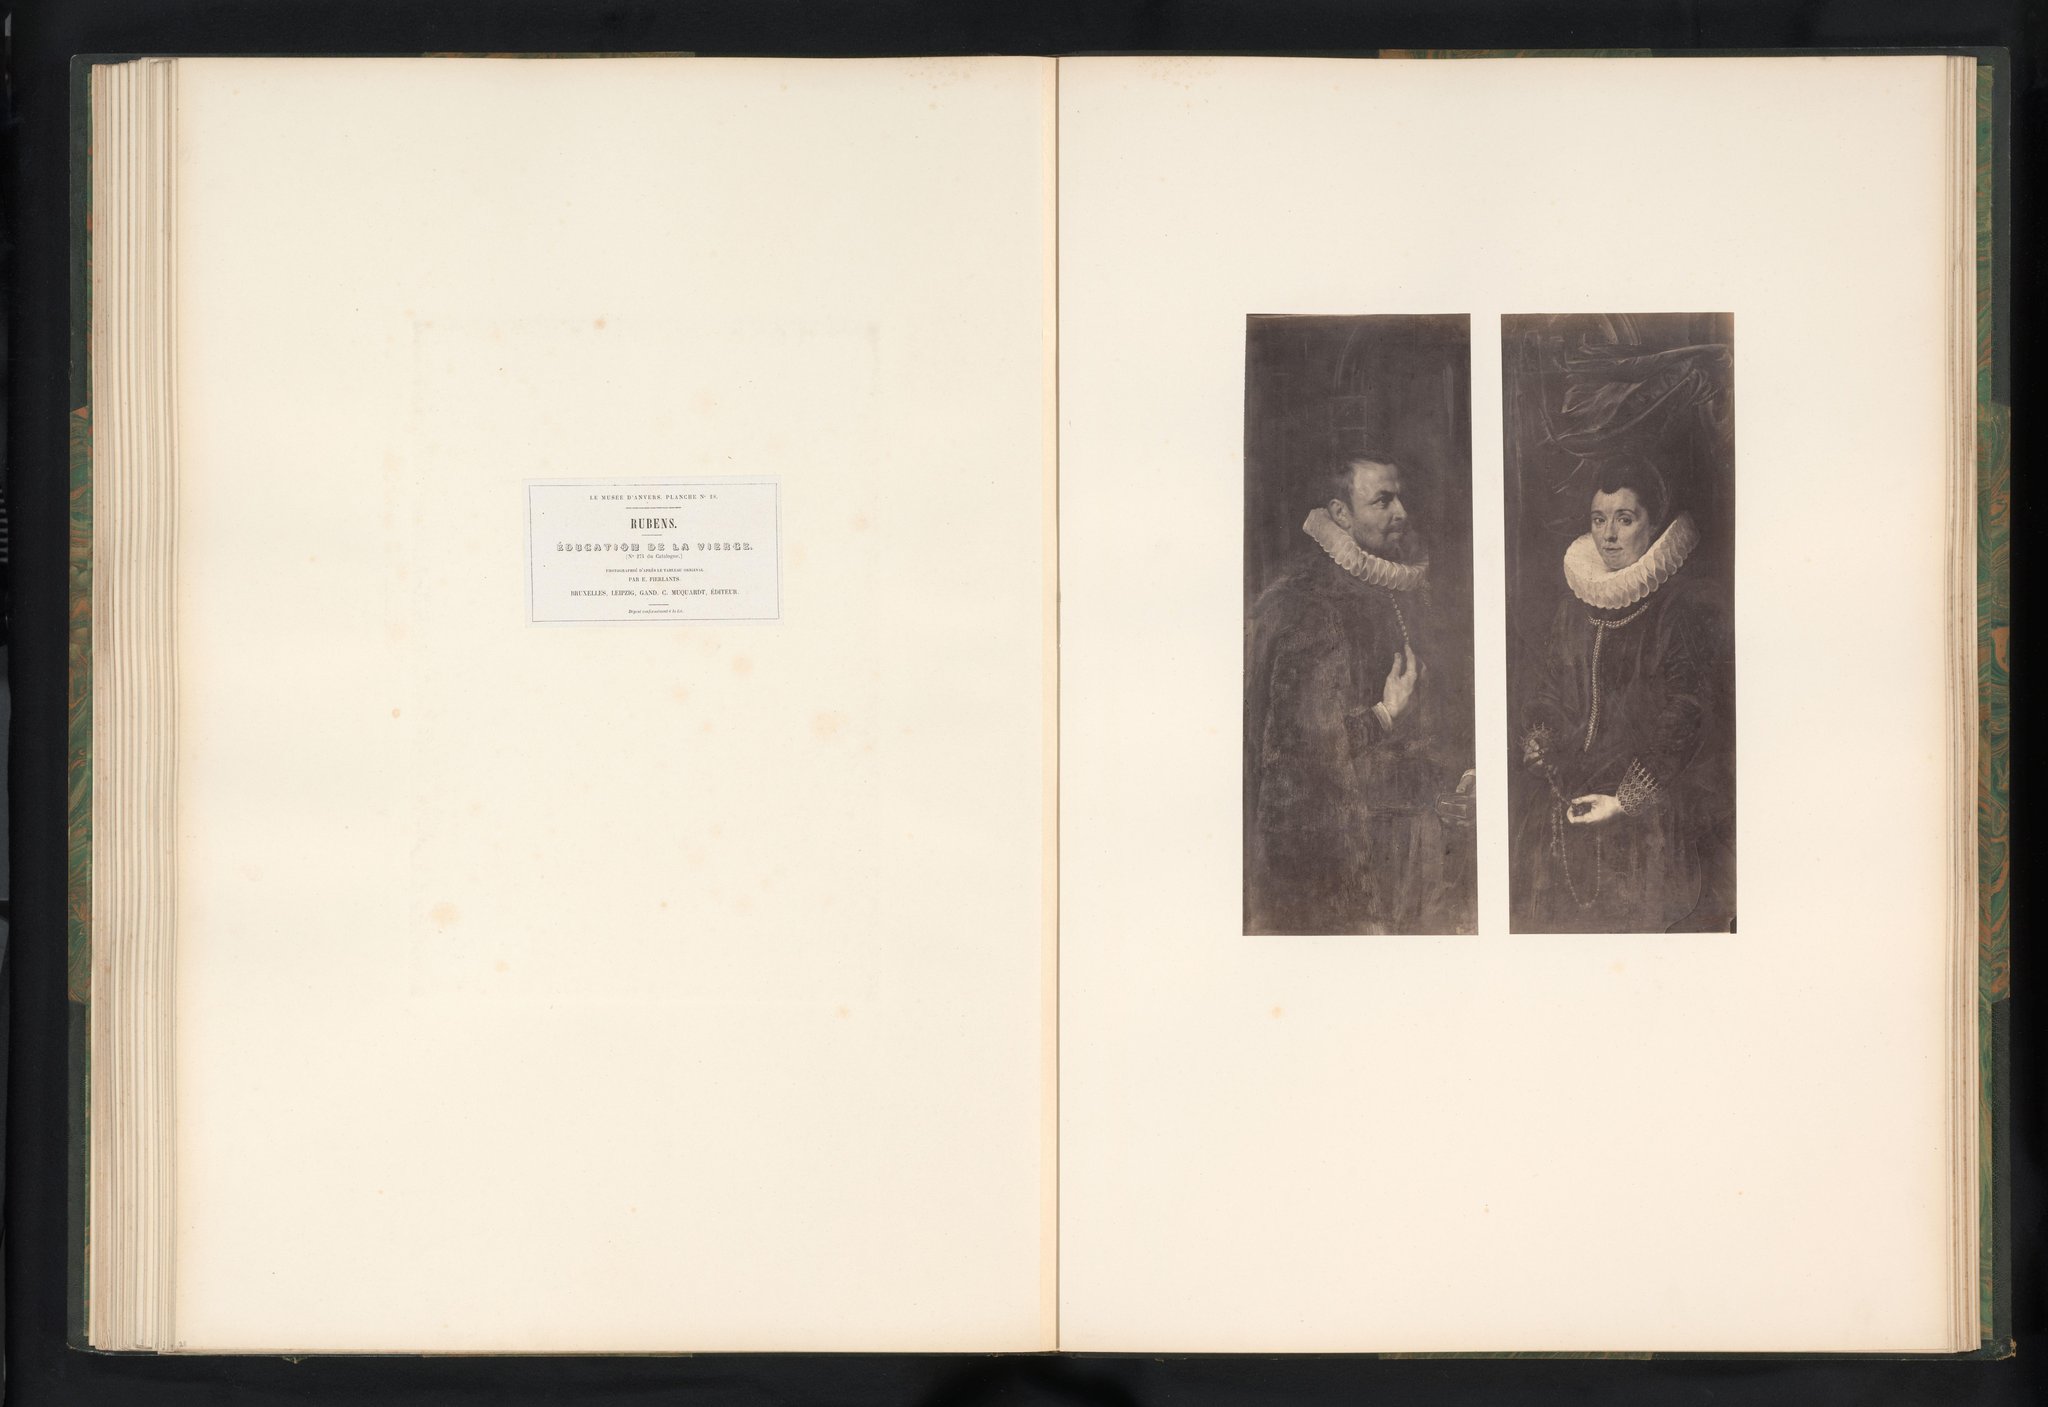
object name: photograph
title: Fotoreproducties van Nicolaas Rockox, burgemeester van Antwerpen en van Adriana Perez door Peter Paul Rubens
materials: photographic support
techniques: albumen print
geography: brussels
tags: antwerp, mayor, nikolaas rockox, historical persons - bb - woman, historical persons